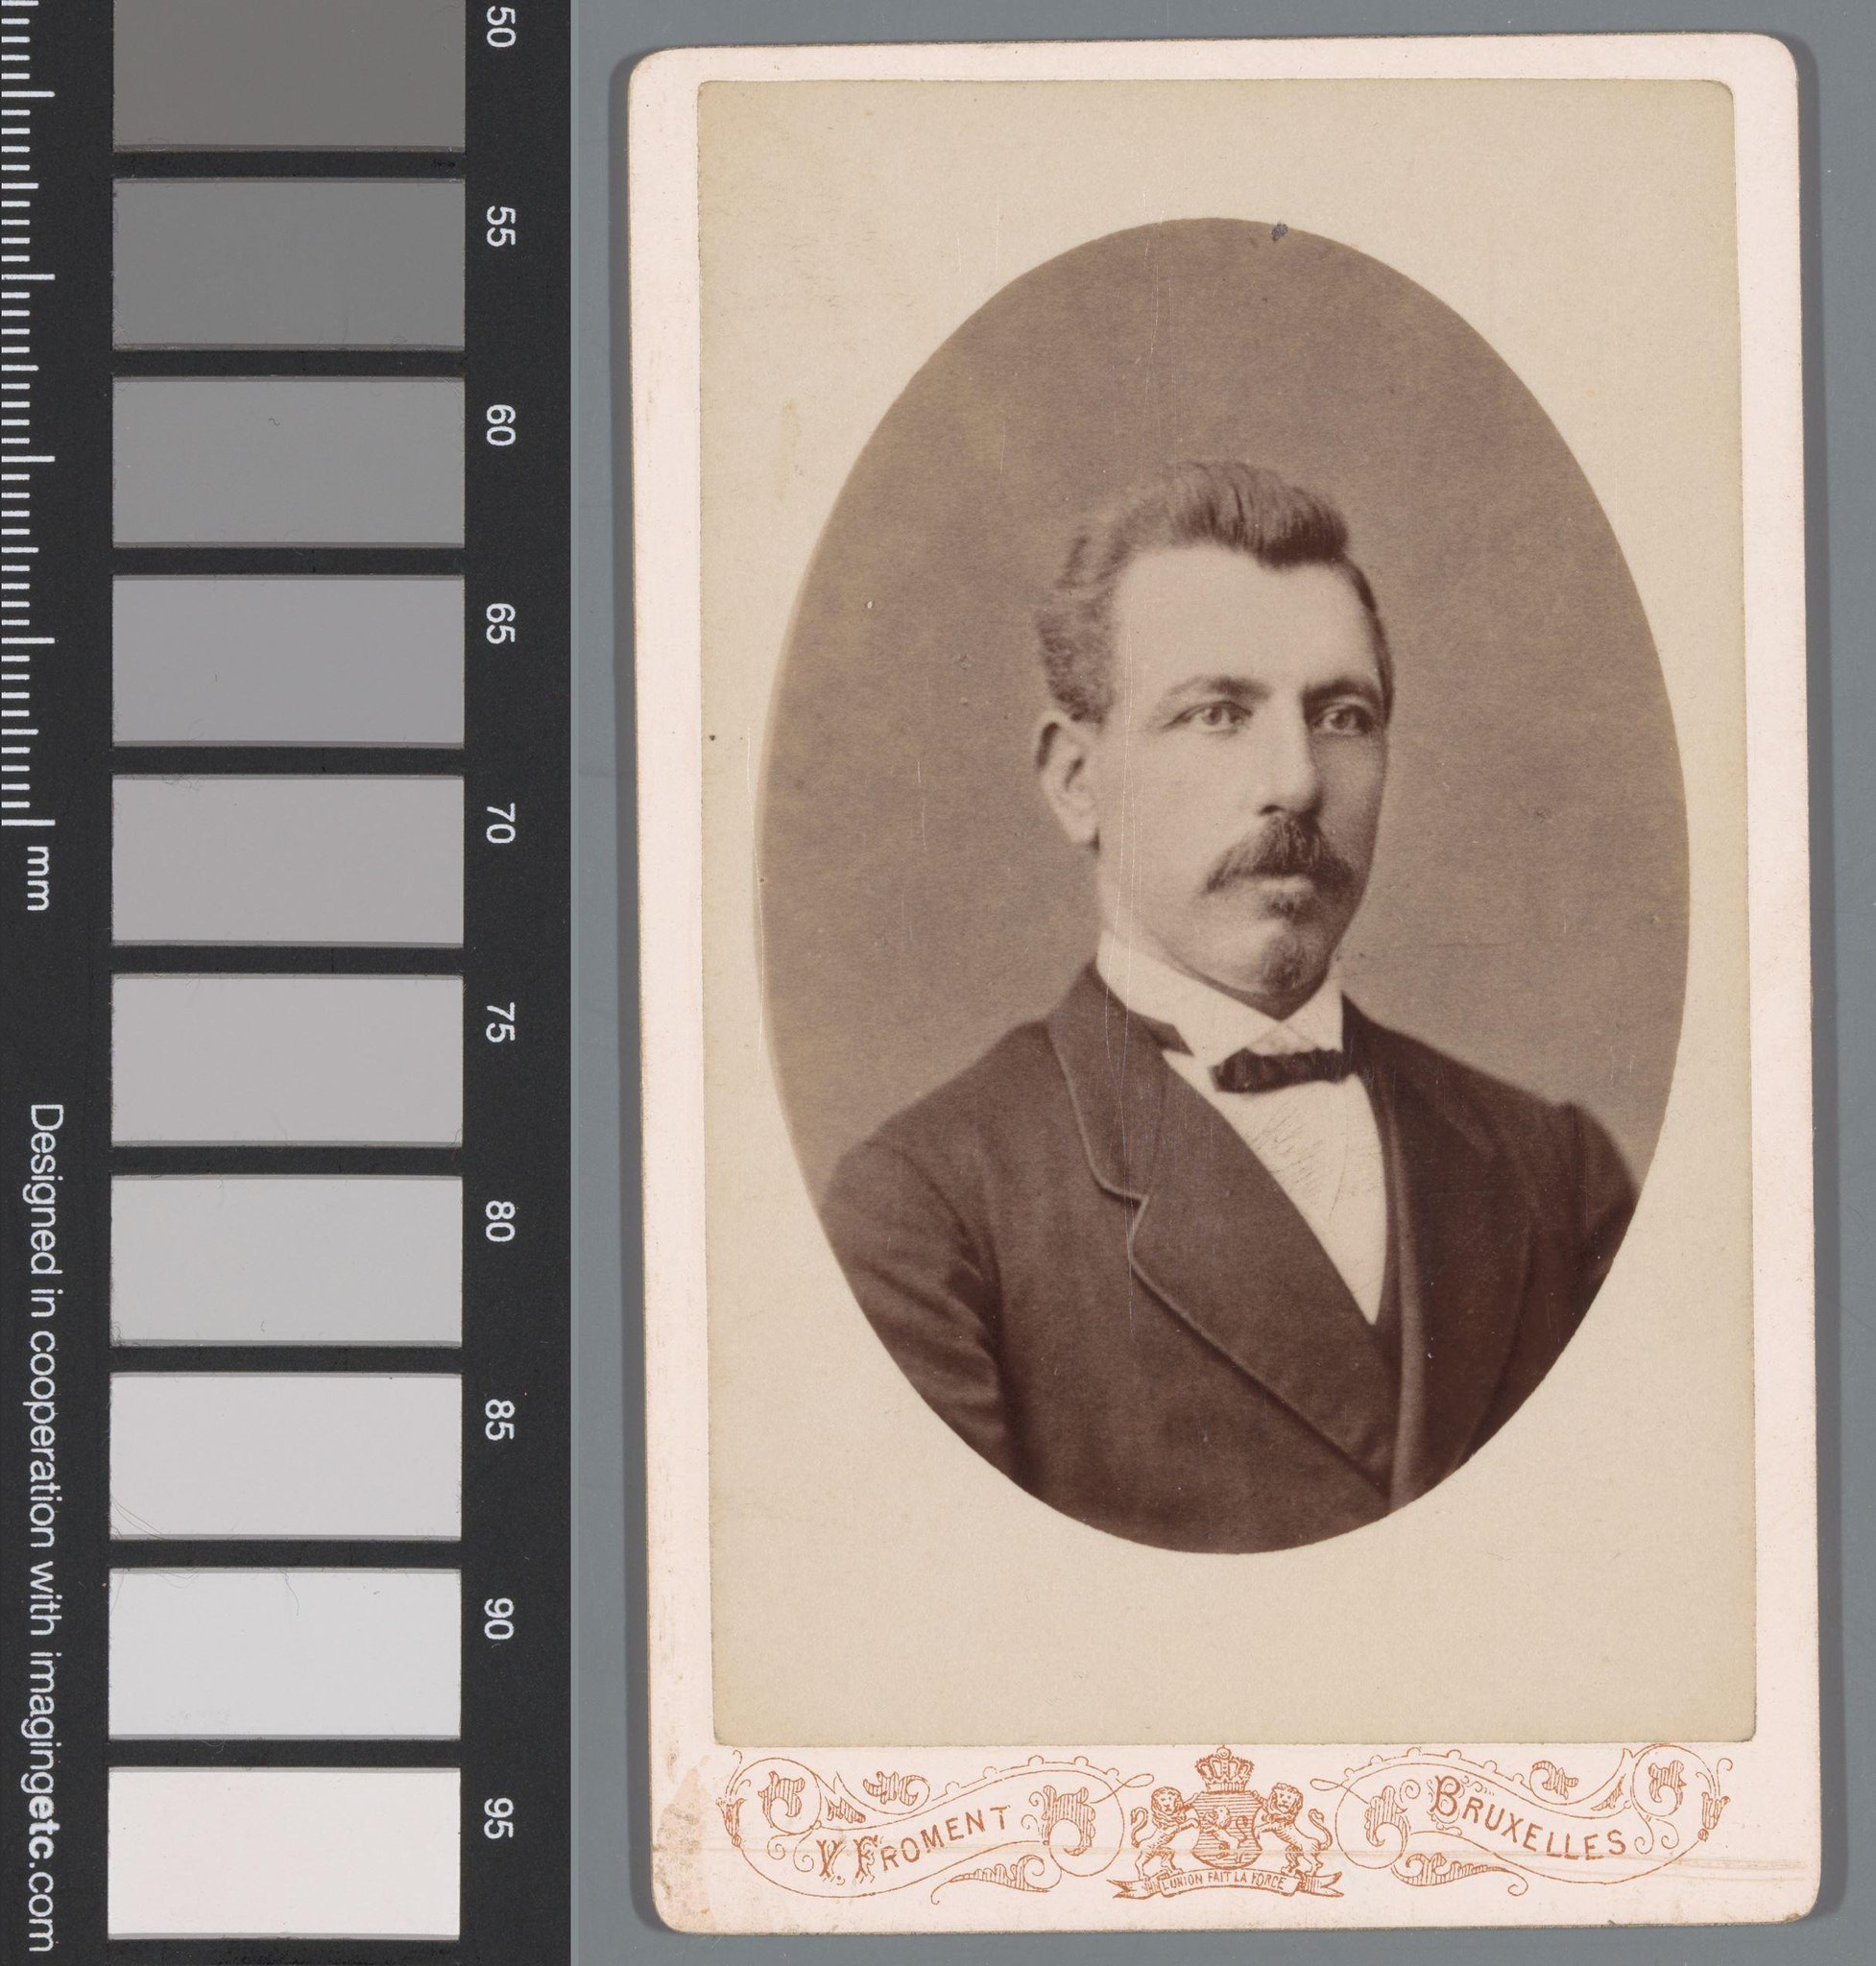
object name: photograph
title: Portret van een onbekende man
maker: victor froment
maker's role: fotograaf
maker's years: 1842-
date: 1885-1890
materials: cardboard, paper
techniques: albumen print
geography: brussels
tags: adult man, anonymous historical person portrayed, brussels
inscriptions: inscription: ‘V. Froment/ 19, Rue du Fossé aux Loups 18,/ Place de la Monnaie/ Bruxelles./ Ancienne Maison Delabarre./ Les clichés sont conservés.’, inscription: ‘V. Froment Bruxelles’